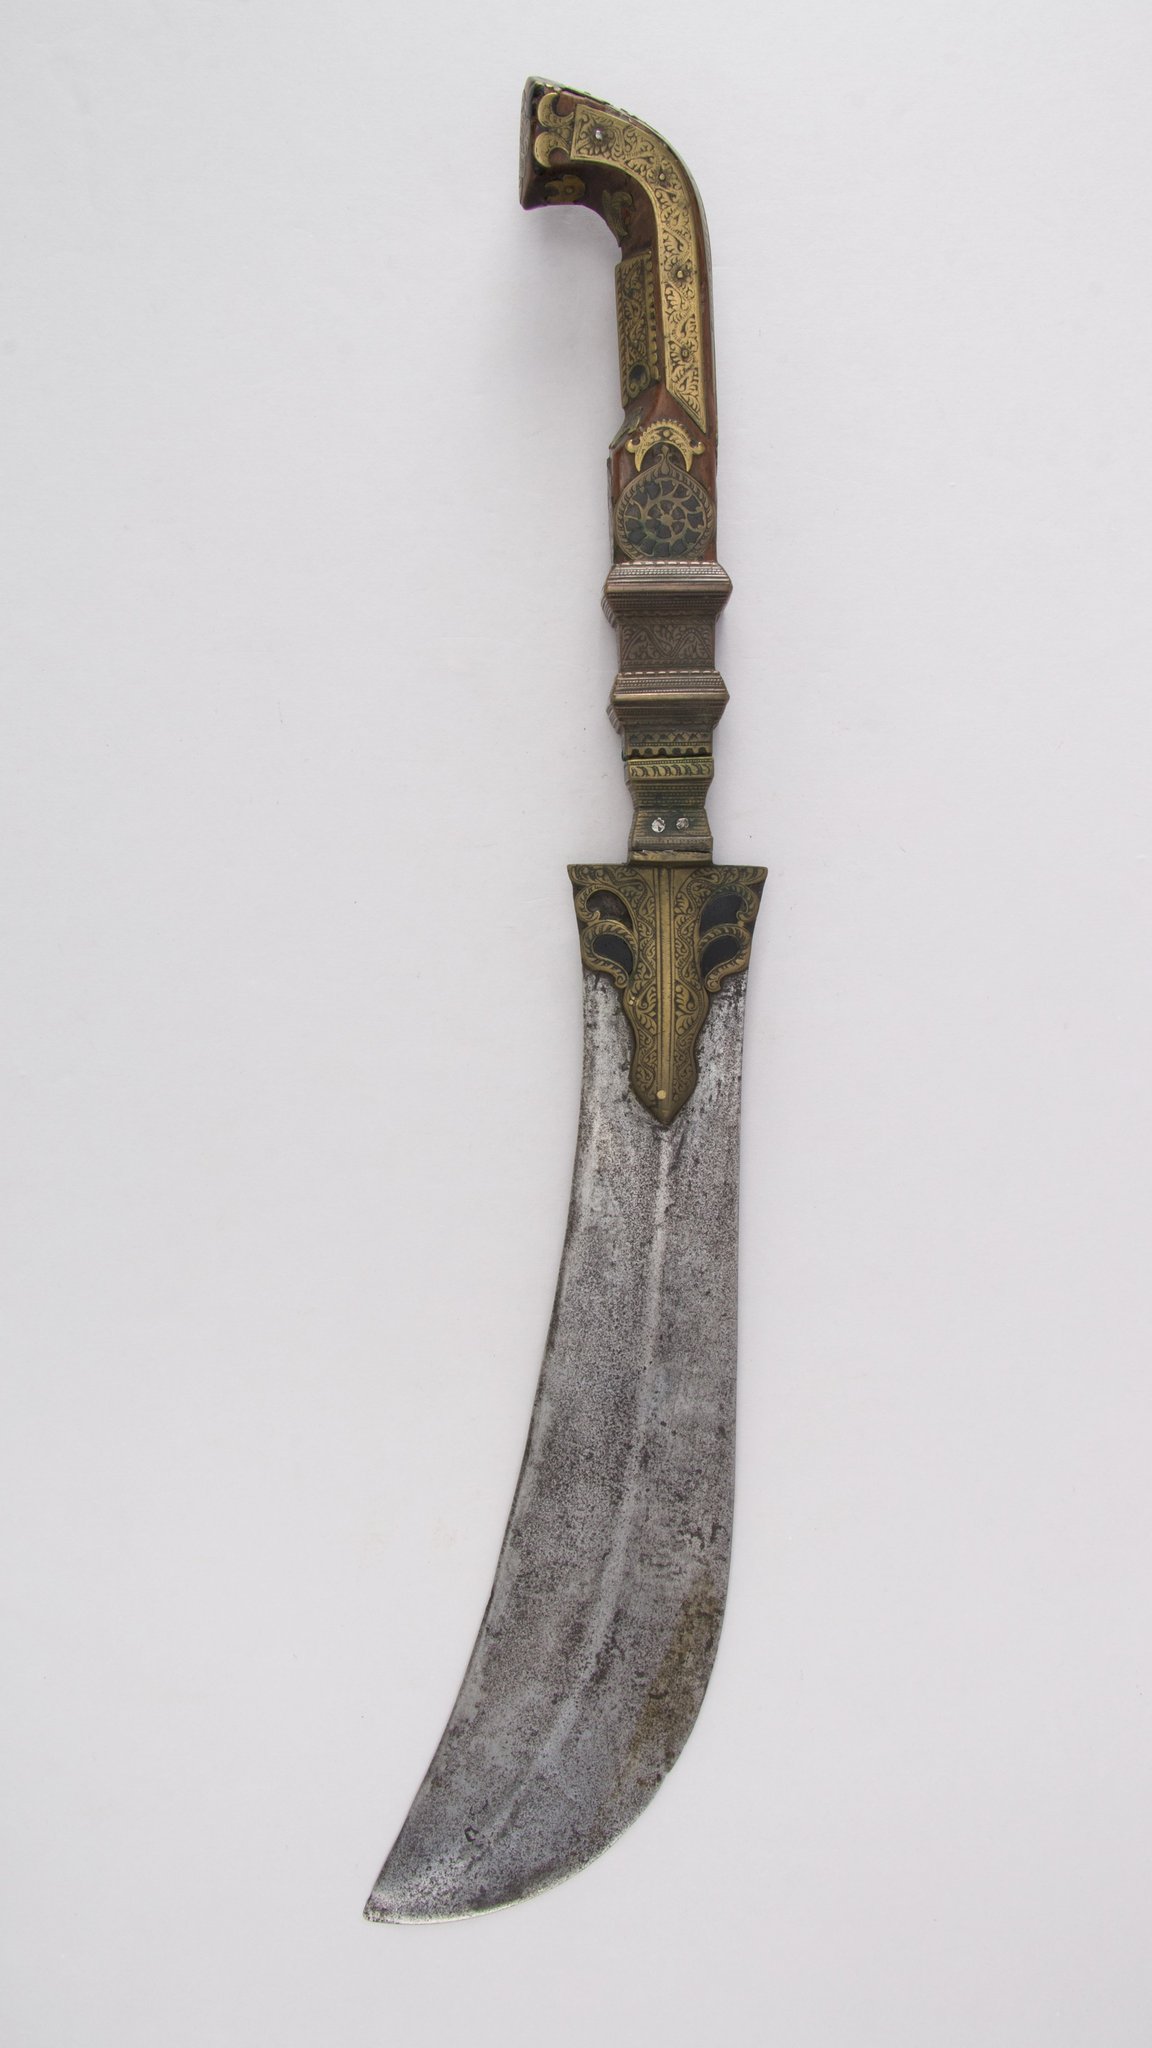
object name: knife i moplah i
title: Knife (Moplah)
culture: indian, kodagu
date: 1701-1900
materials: brass, paste, steel, wood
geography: india